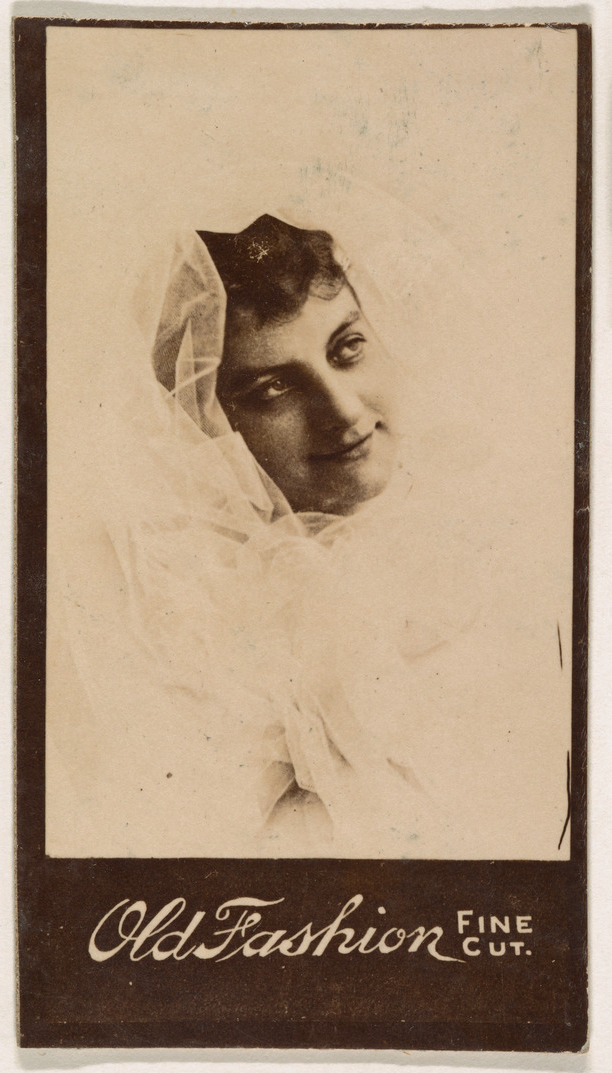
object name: photograph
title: Actress wearing shawl on head, from the Actresses series (N664) promoting Old Fashion Fine Cut Tobacco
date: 1888-1890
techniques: albumen silver print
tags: portraits,women,actresses